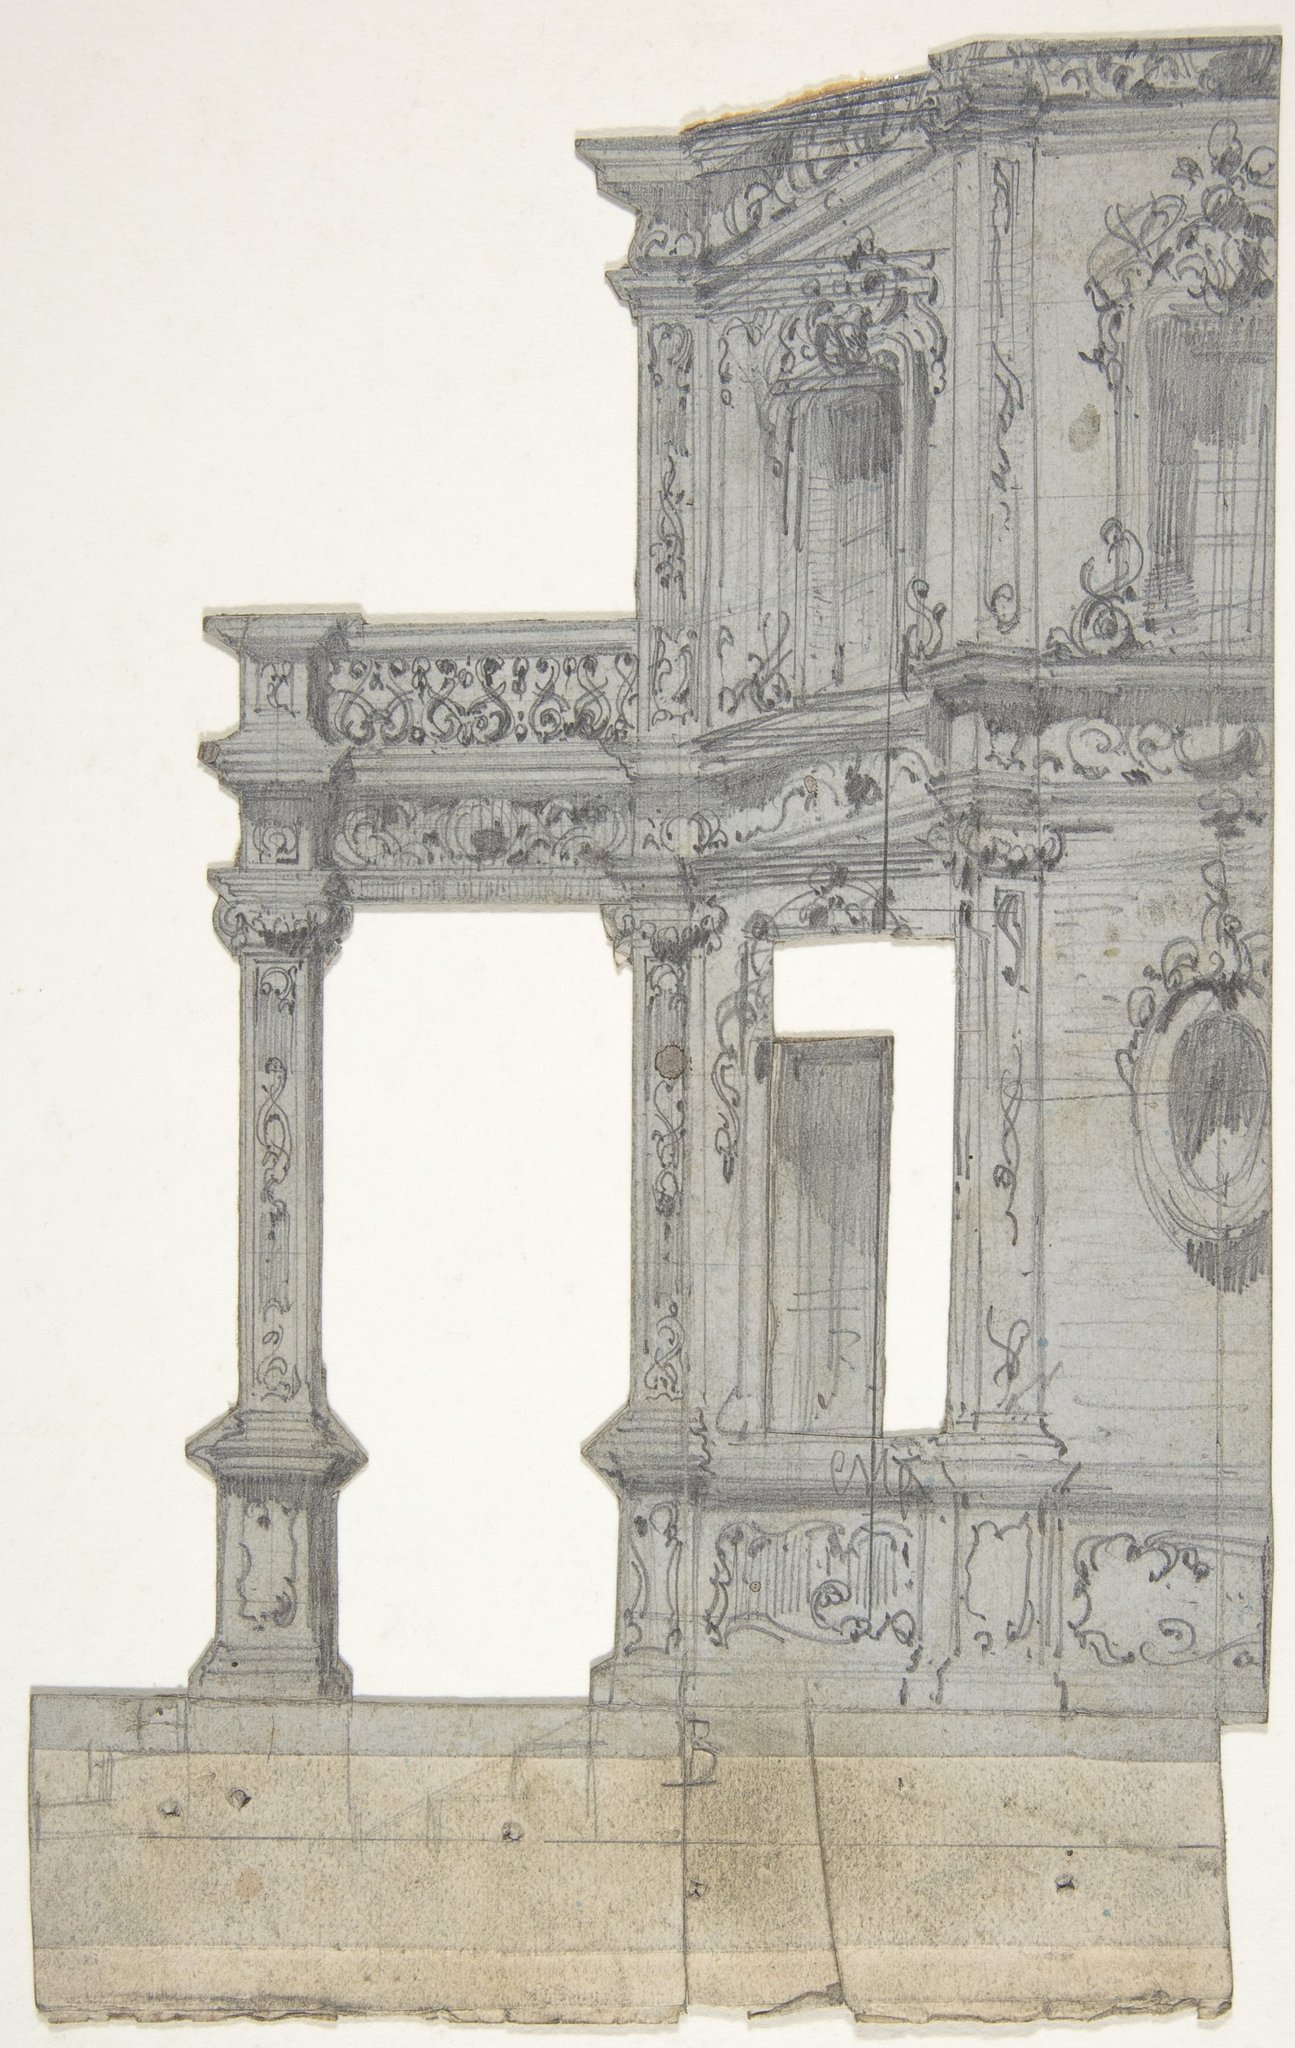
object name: drawing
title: Design for a Stage Set at the Opéra, Paris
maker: eugène cicéri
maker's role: artist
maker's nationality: french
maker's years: 1813-1890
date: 1830-1890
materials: graphite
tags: buildings,stage design